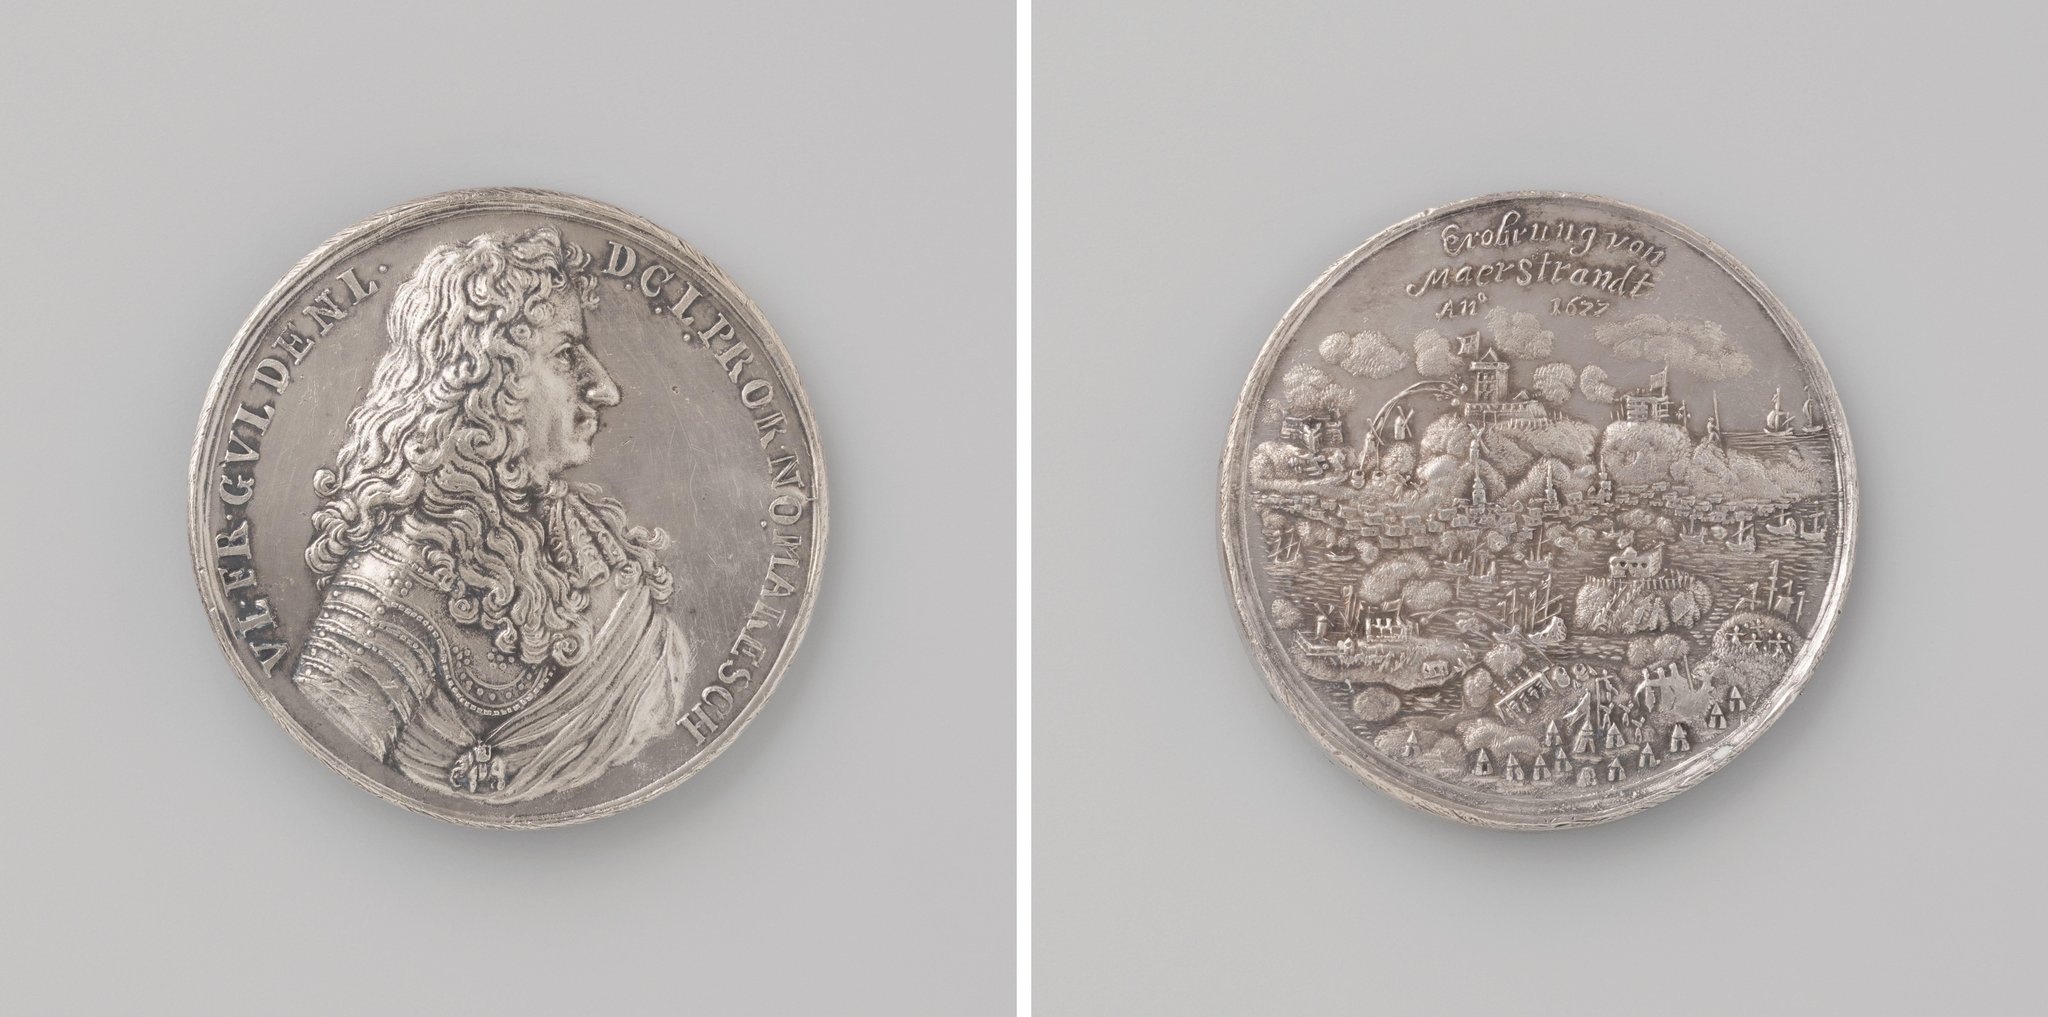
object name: history medal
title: Verovering van Marstrandt door de graaf van Guldenleeuw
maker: Anonymous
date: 1677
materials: silver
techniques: striking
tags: bremen, hamburg, generaal, ulrik frederik gyldenløve, zweden, marstrand, inname van marstrand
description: Zilveren penning. Voorzijde: borststuk man binnen omschrift. Keerzijde: het veroverde eilanden met zijn ingenomen vestingen onder opschrift.